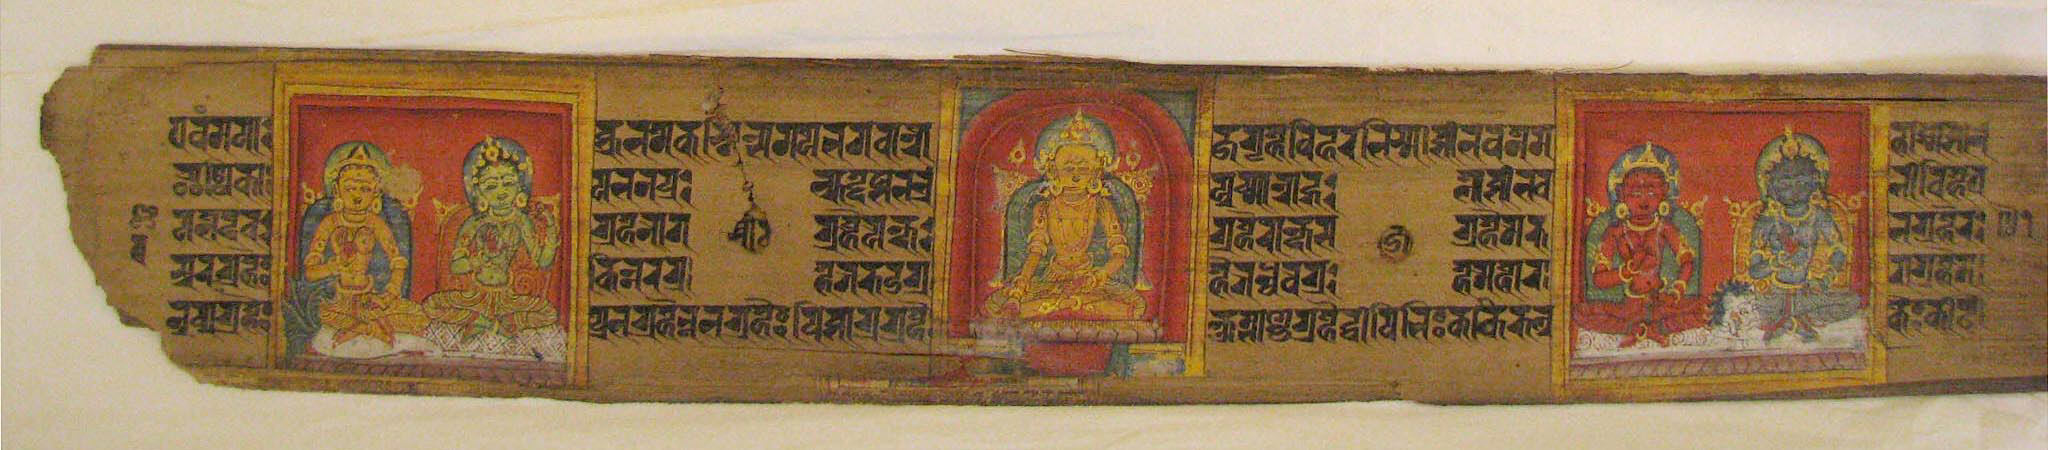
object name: folio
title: Leaf from an Illuminated Buddhist Manuscript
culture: nepali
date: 1301-1400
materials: ink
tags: buddhism,deities